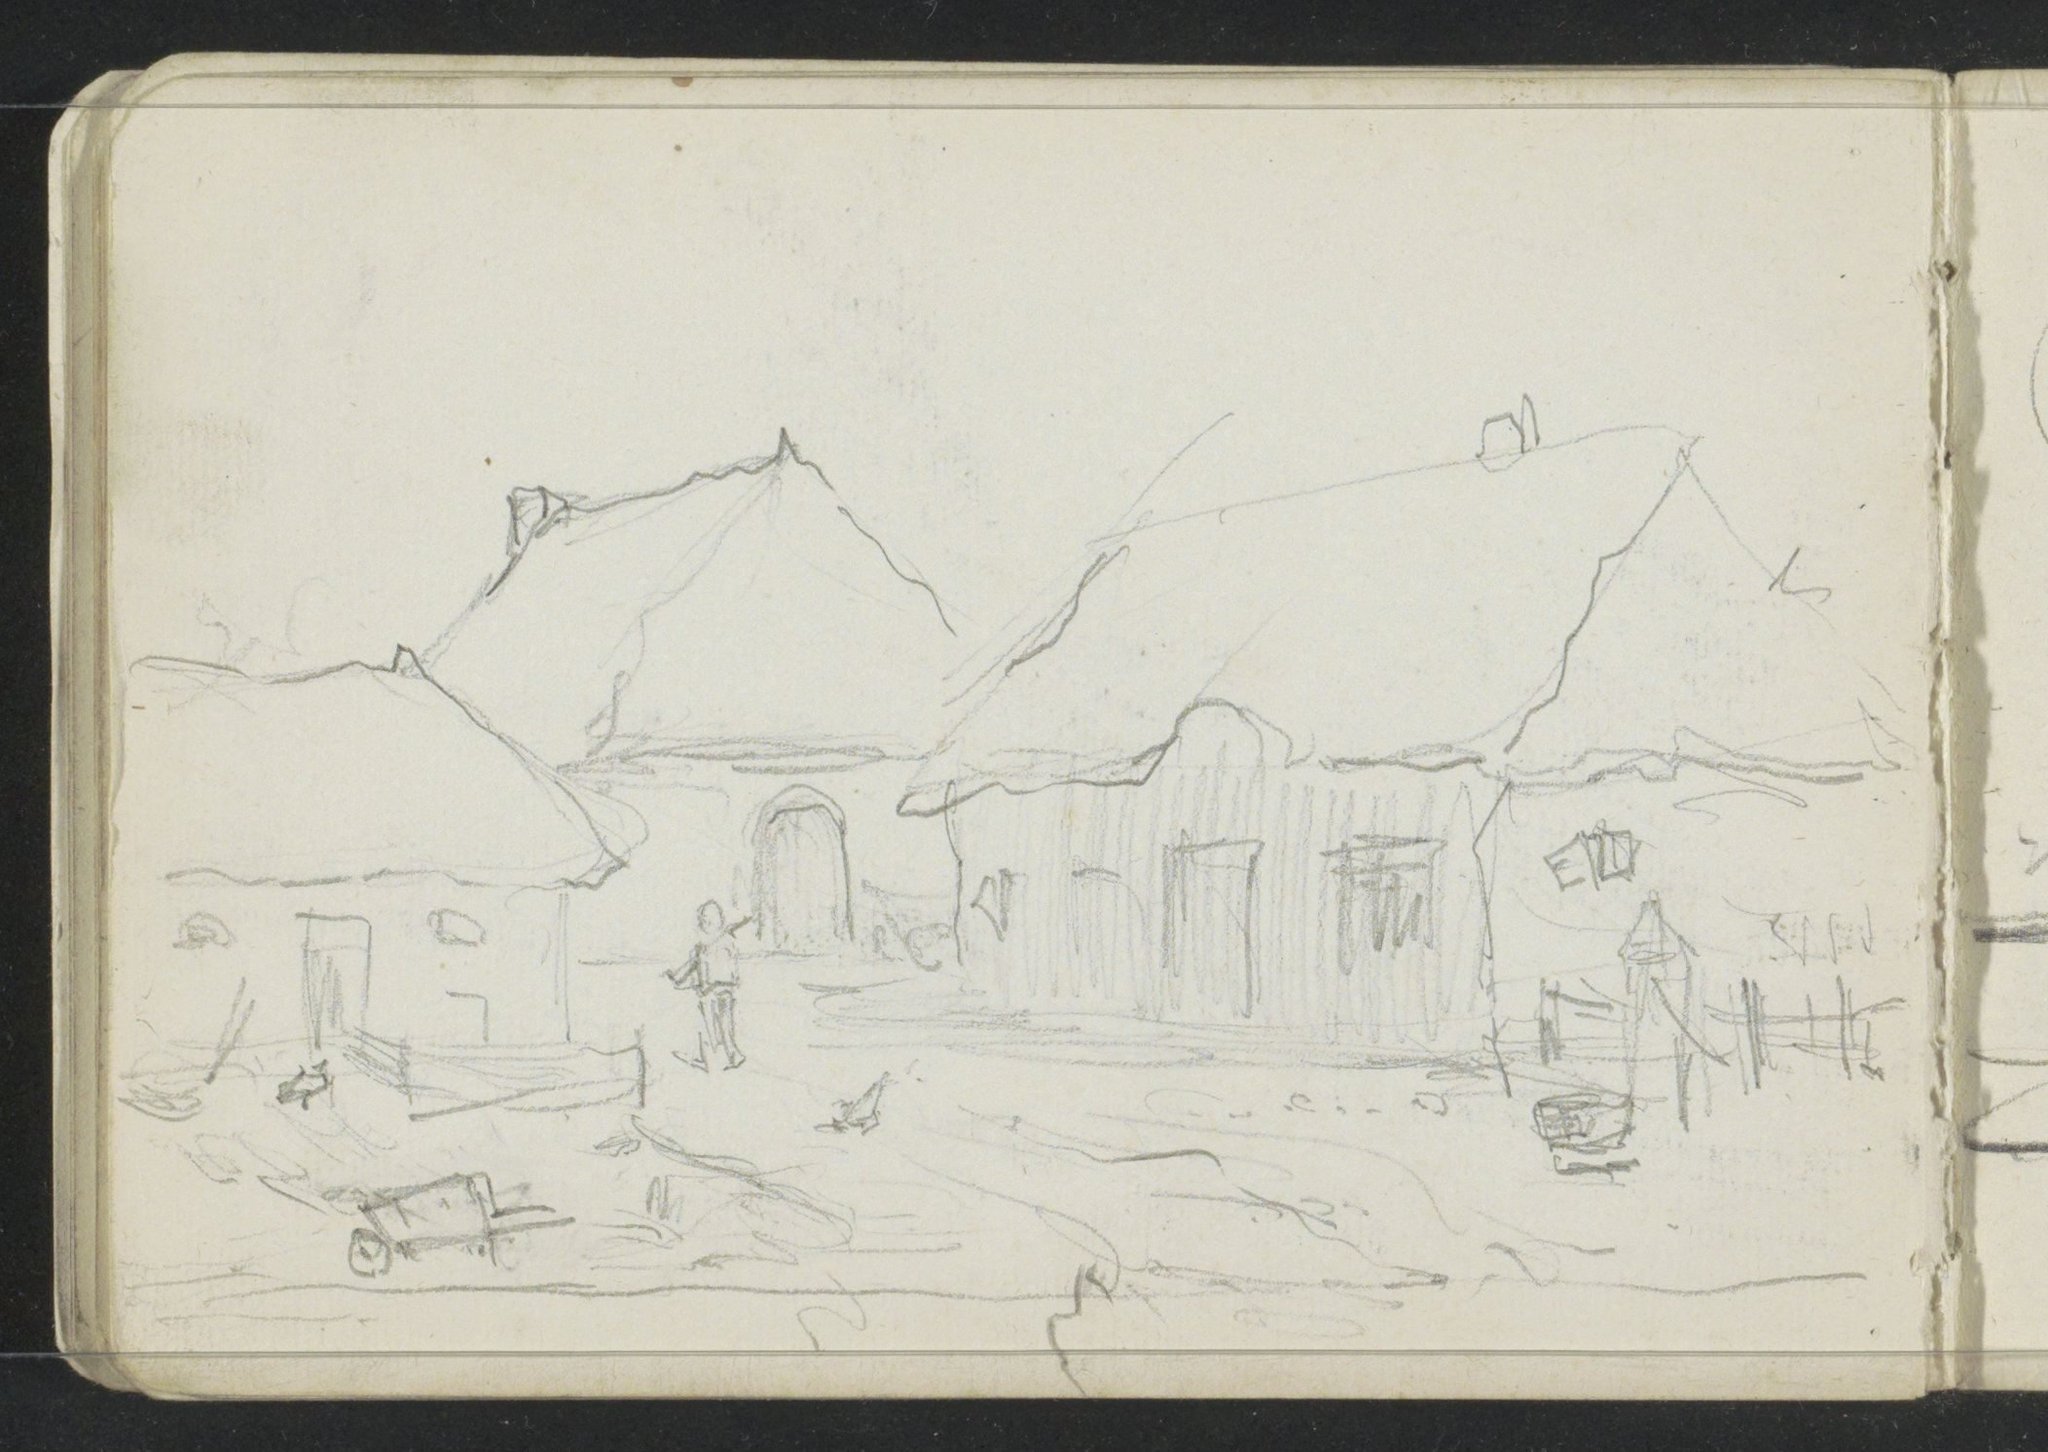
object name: sketchbook leaf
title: Man op het erf van een boerderij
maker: johanna van de kamer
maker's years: 1873-1922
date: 1883-1922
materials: paper, pencil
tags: courtyard, farm (building)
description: Blad 20 verso uit een schetsboek met 27 bladen.